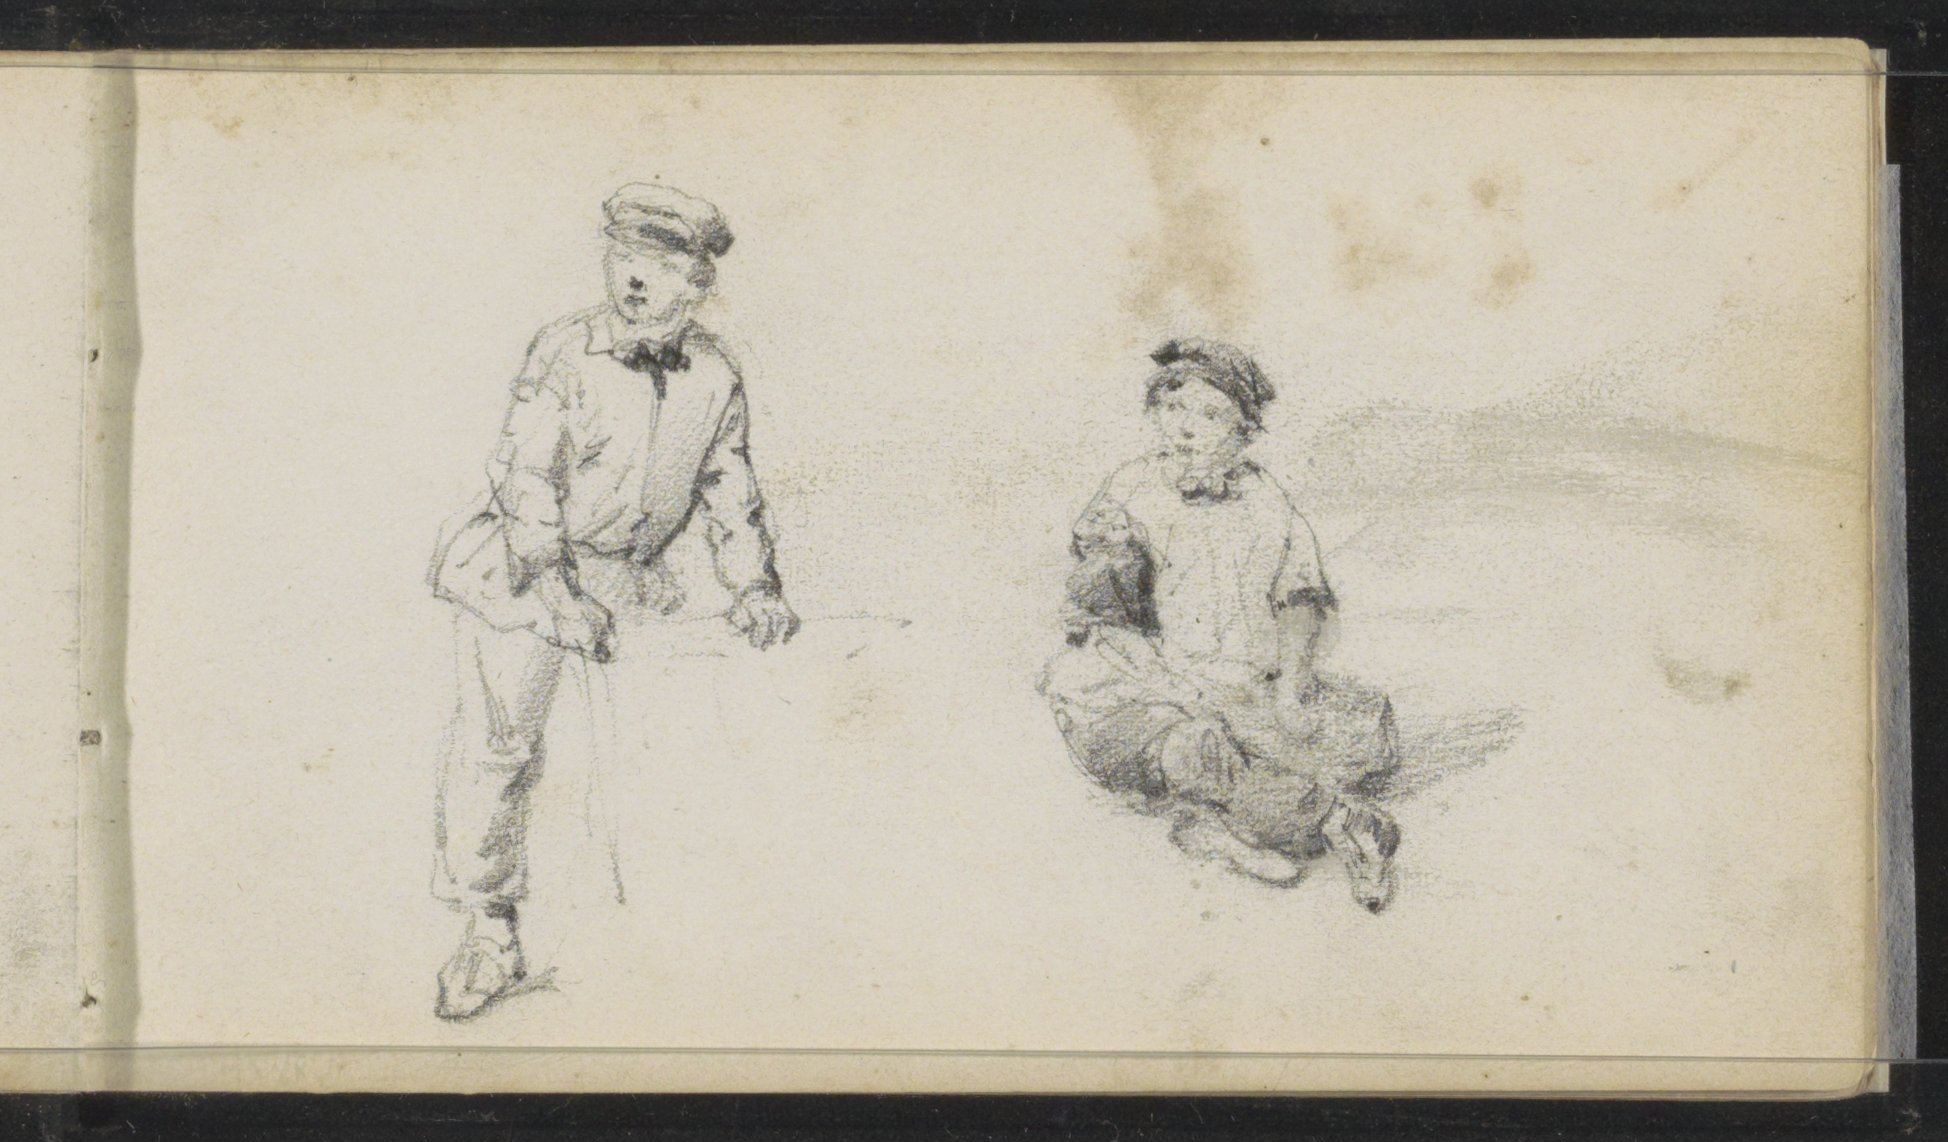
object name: sketchbook leaf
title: Twee figuren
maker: cornelis springer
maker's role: draughtsman, painter, print maker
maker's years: 1817-1891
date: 1860-1866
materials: paper, pencil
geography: netherlands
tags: standing figure, sitting figure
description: Een staande en een zittende figuur. Blad 7 uit een schetsboek met 44 bladen.